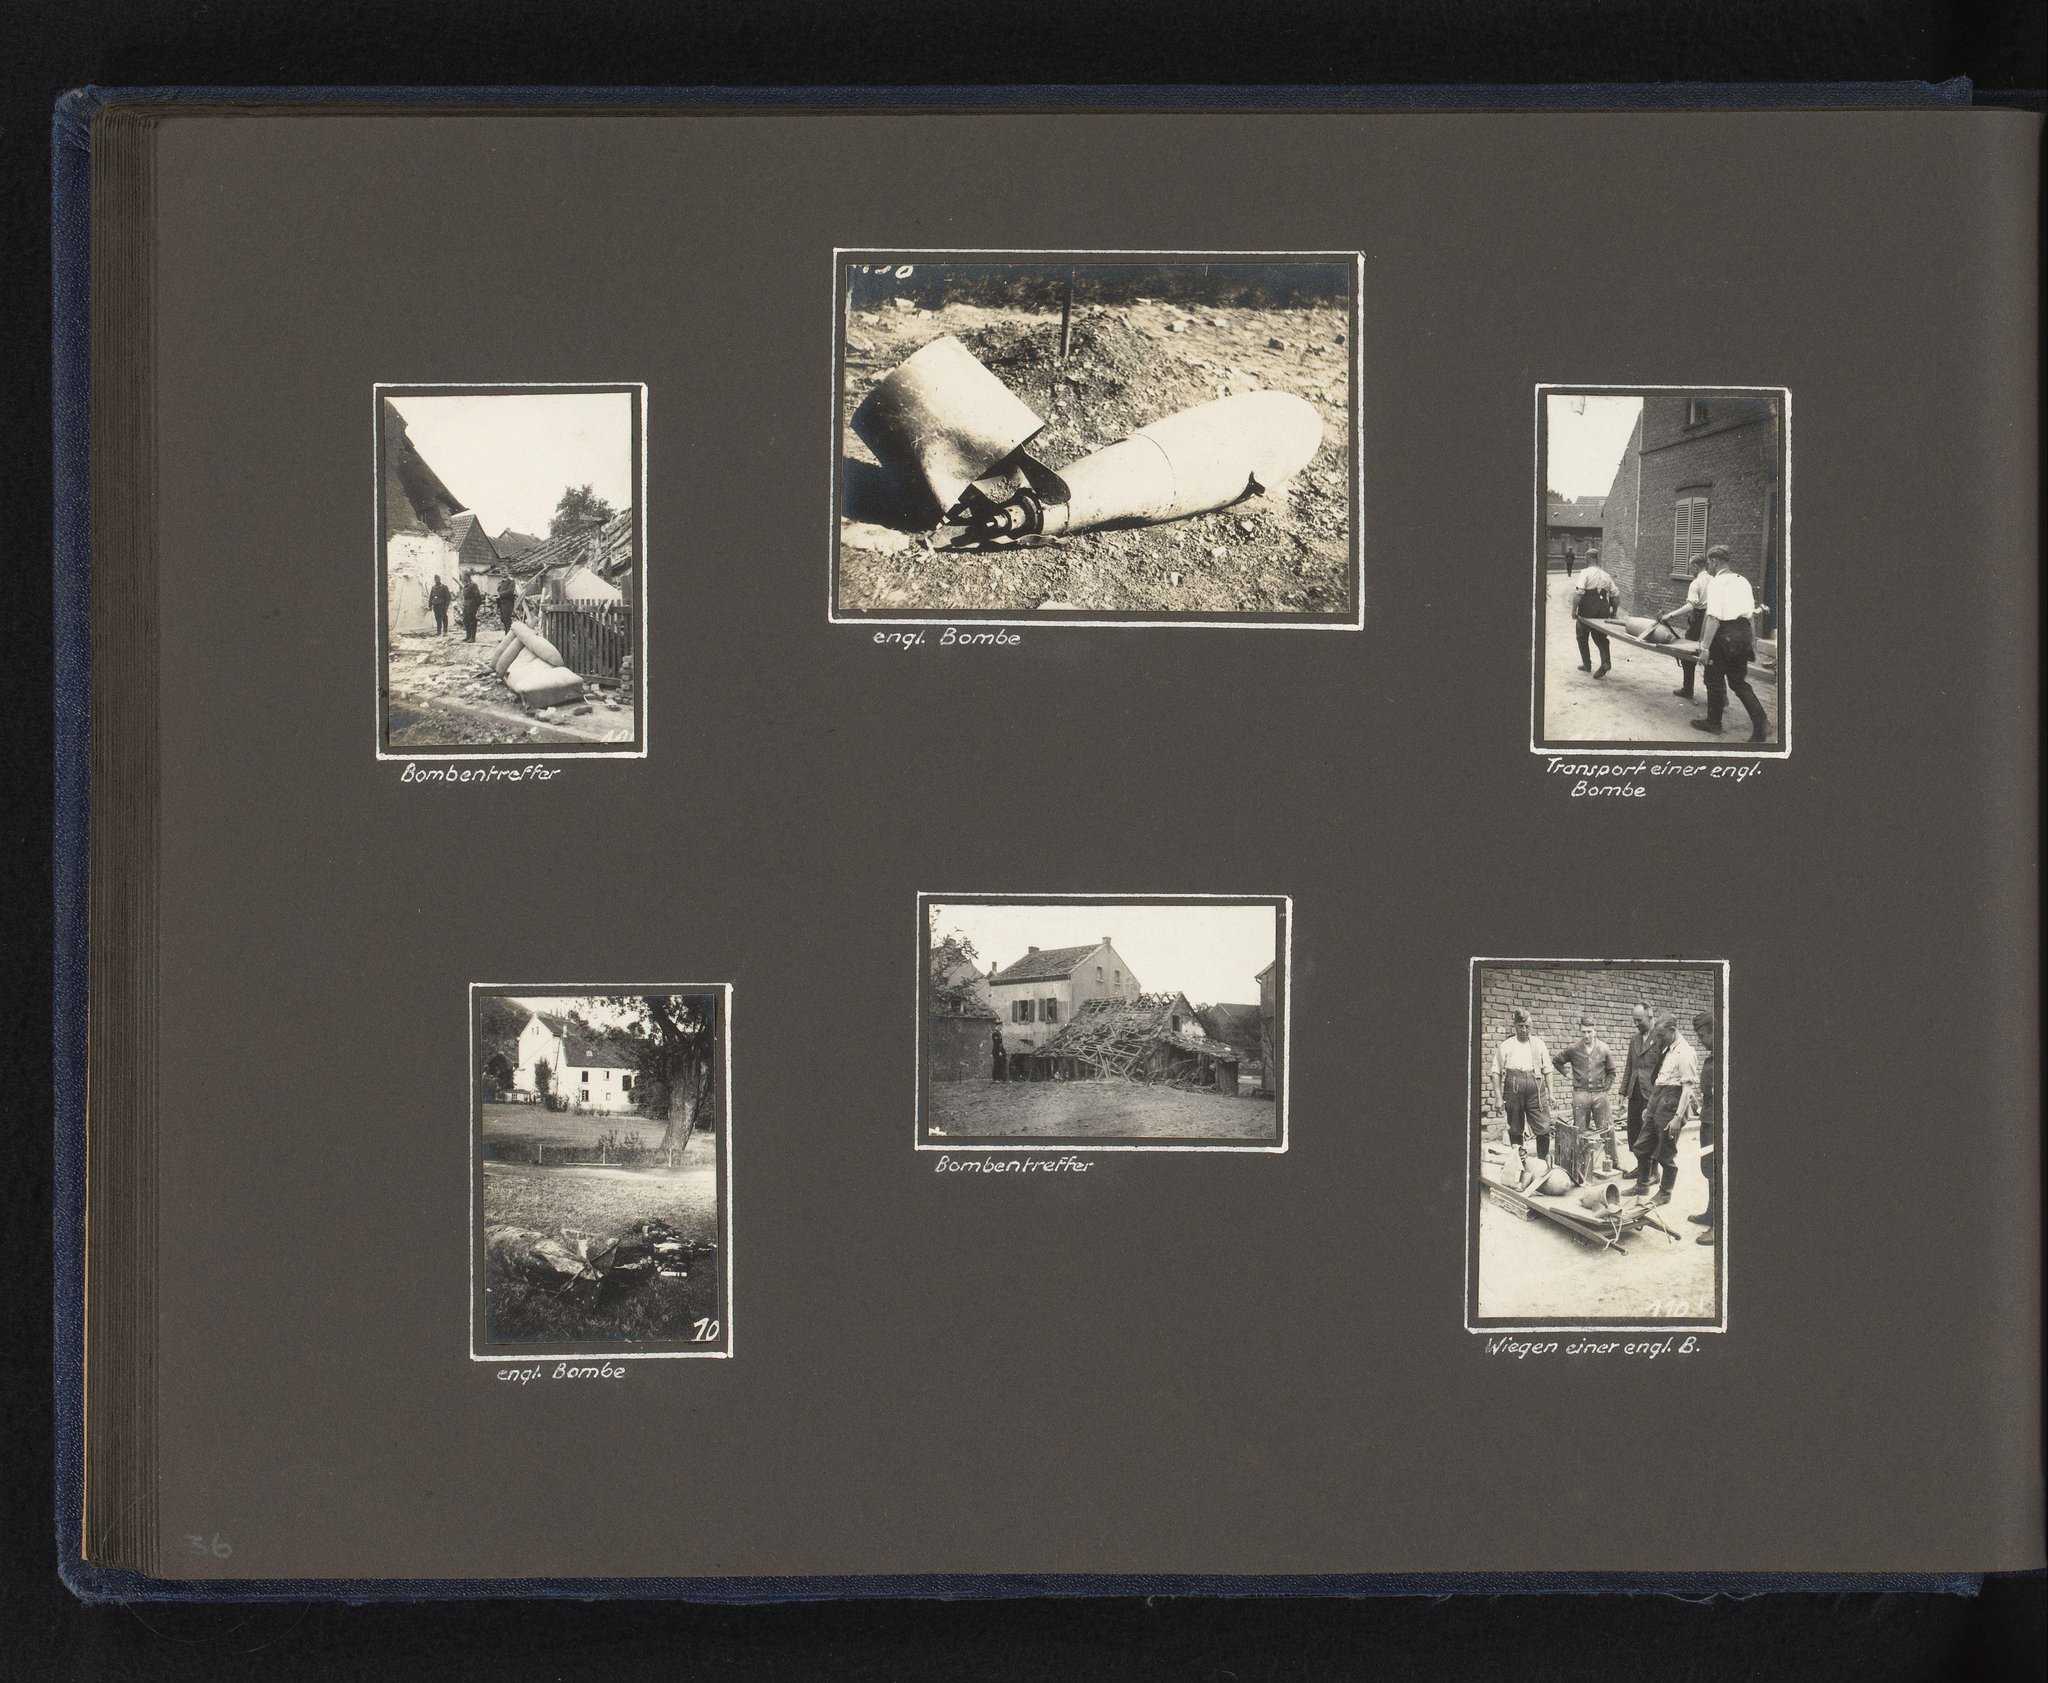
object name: photograph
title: Engelse bommen in Duitsland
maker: Anonymous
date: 1940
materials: cardboard, photographic support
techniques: gelatin silver print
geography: germany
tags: projectiles, explosives, etc. (with name), devastated, ruined place or city (~ warfare), germany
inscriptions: inscription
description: Albumblad met zes foto's van gebouwen in Duitsland getroffen door Engelse bommen. Een blindganger wordt afgevoerd en gewogen. Onderdeel van een Duits militair album Tweede Wereldoorlog 1939-1940.